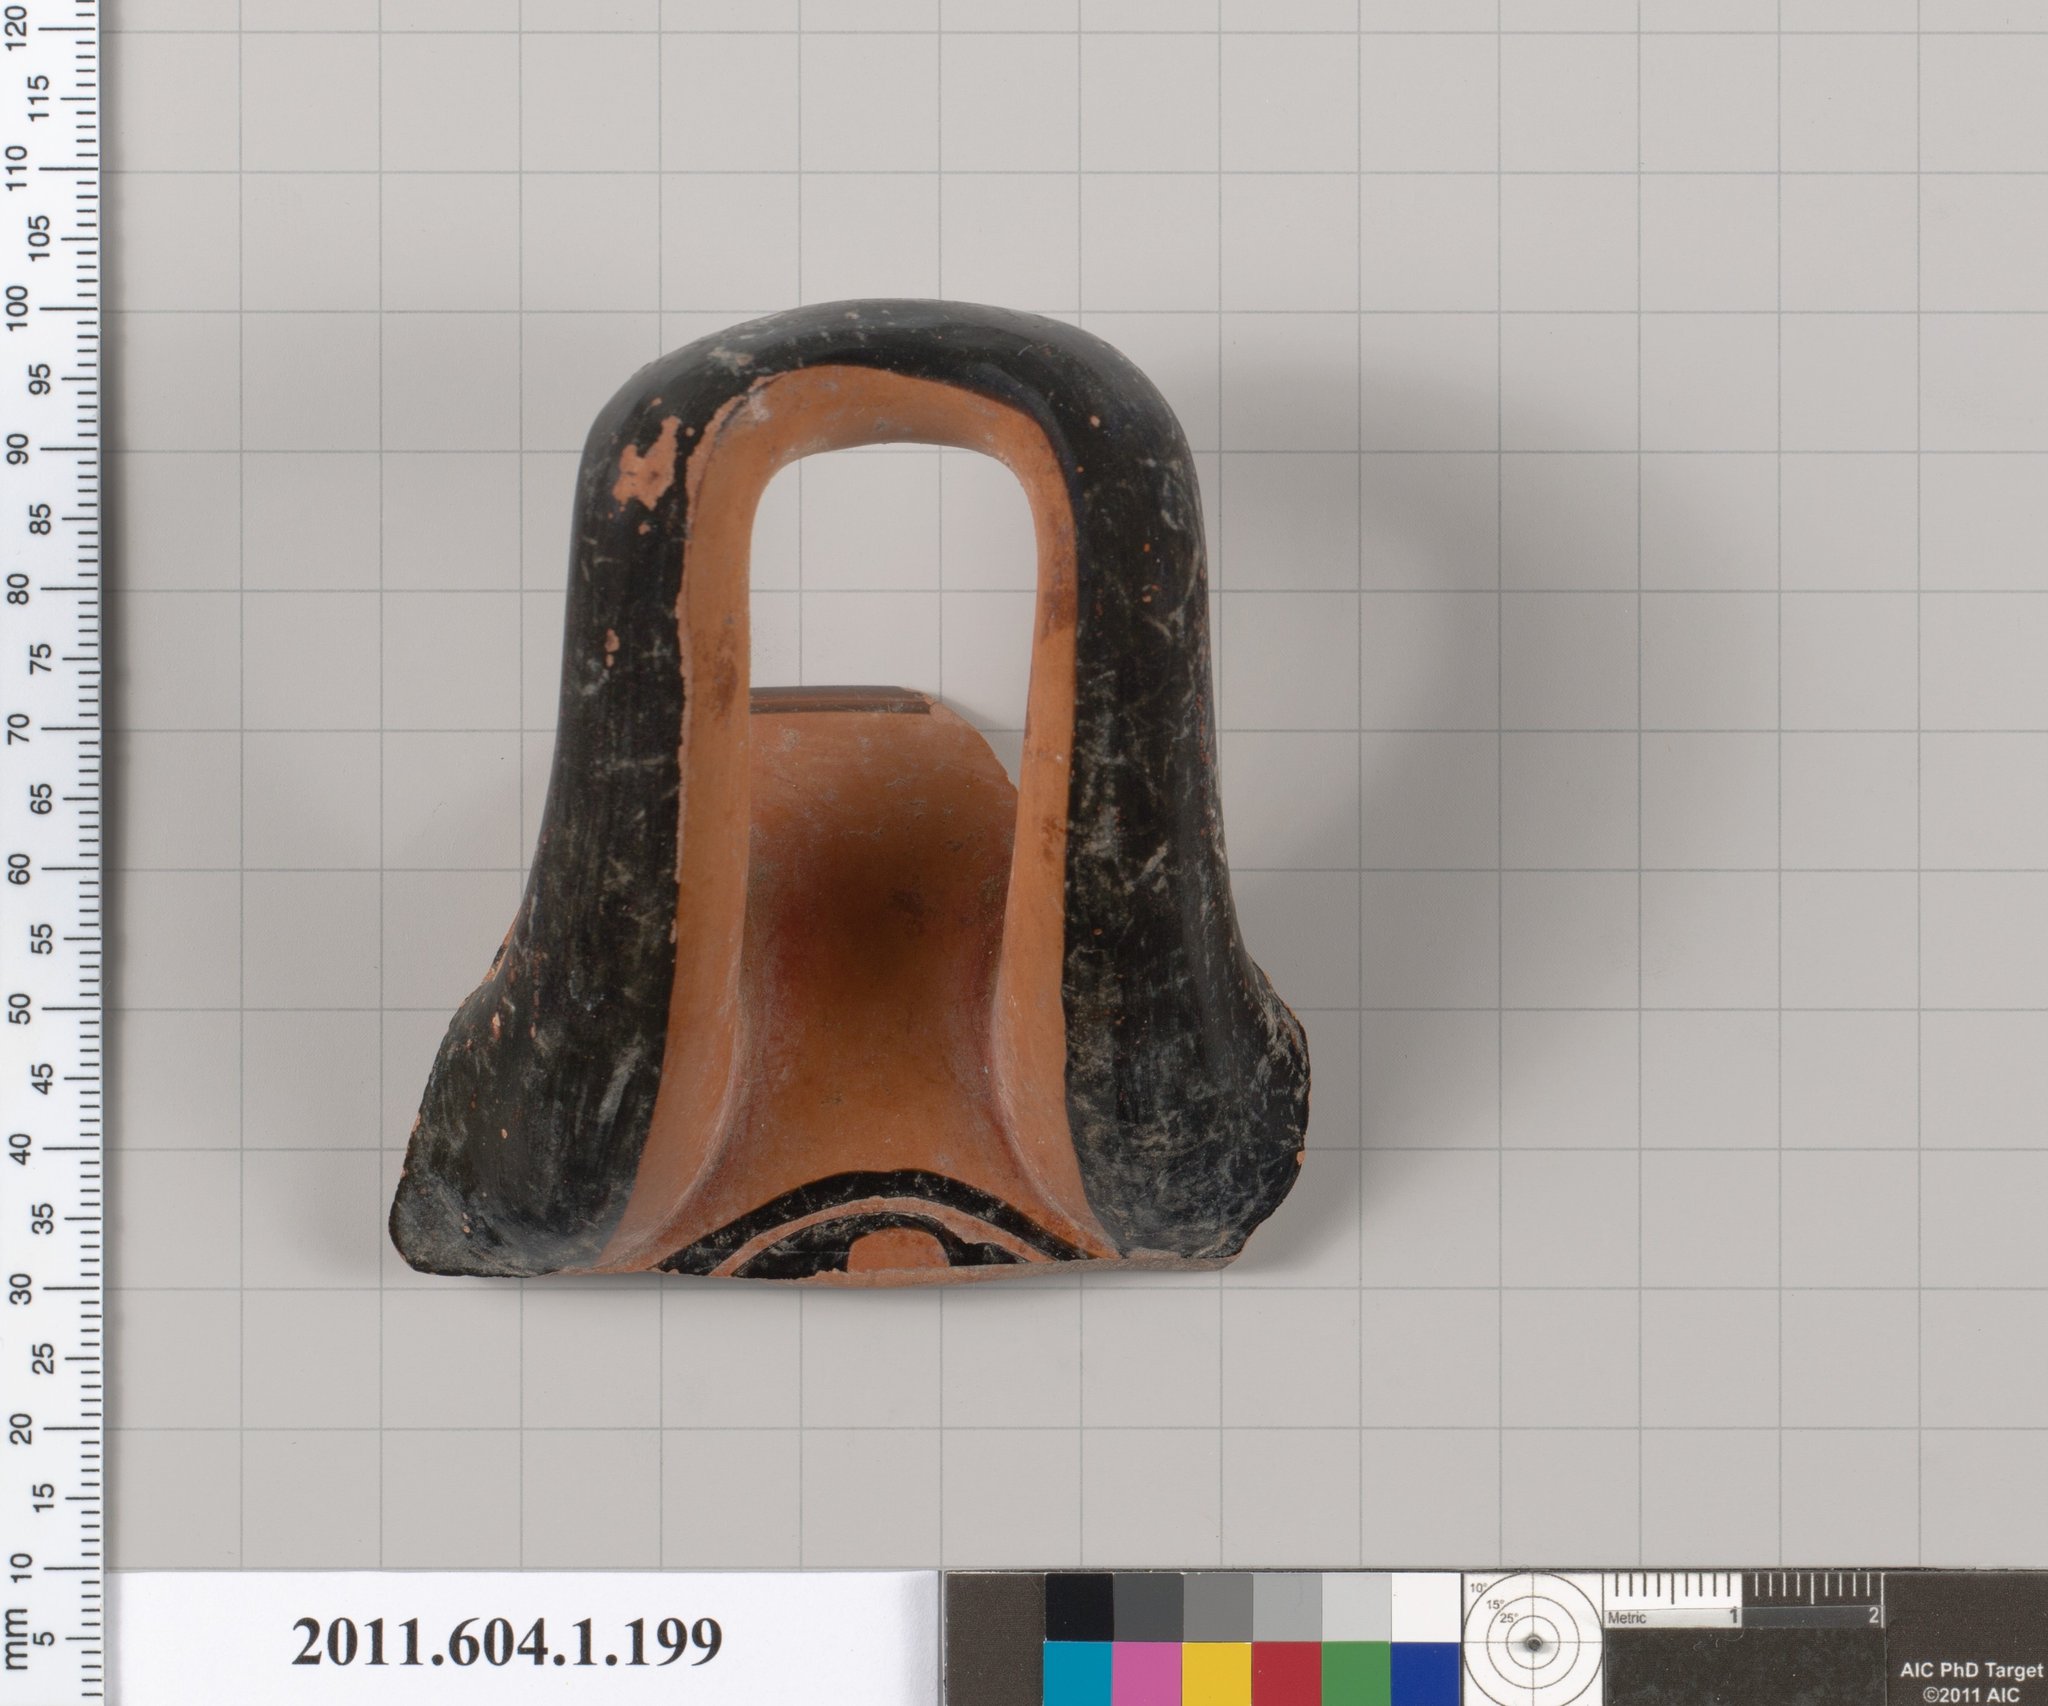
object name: kylix fragment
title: Terracotta fragment of a kylix (drinking cup)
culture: greek, attic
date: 475-451 BCE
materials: terracotta